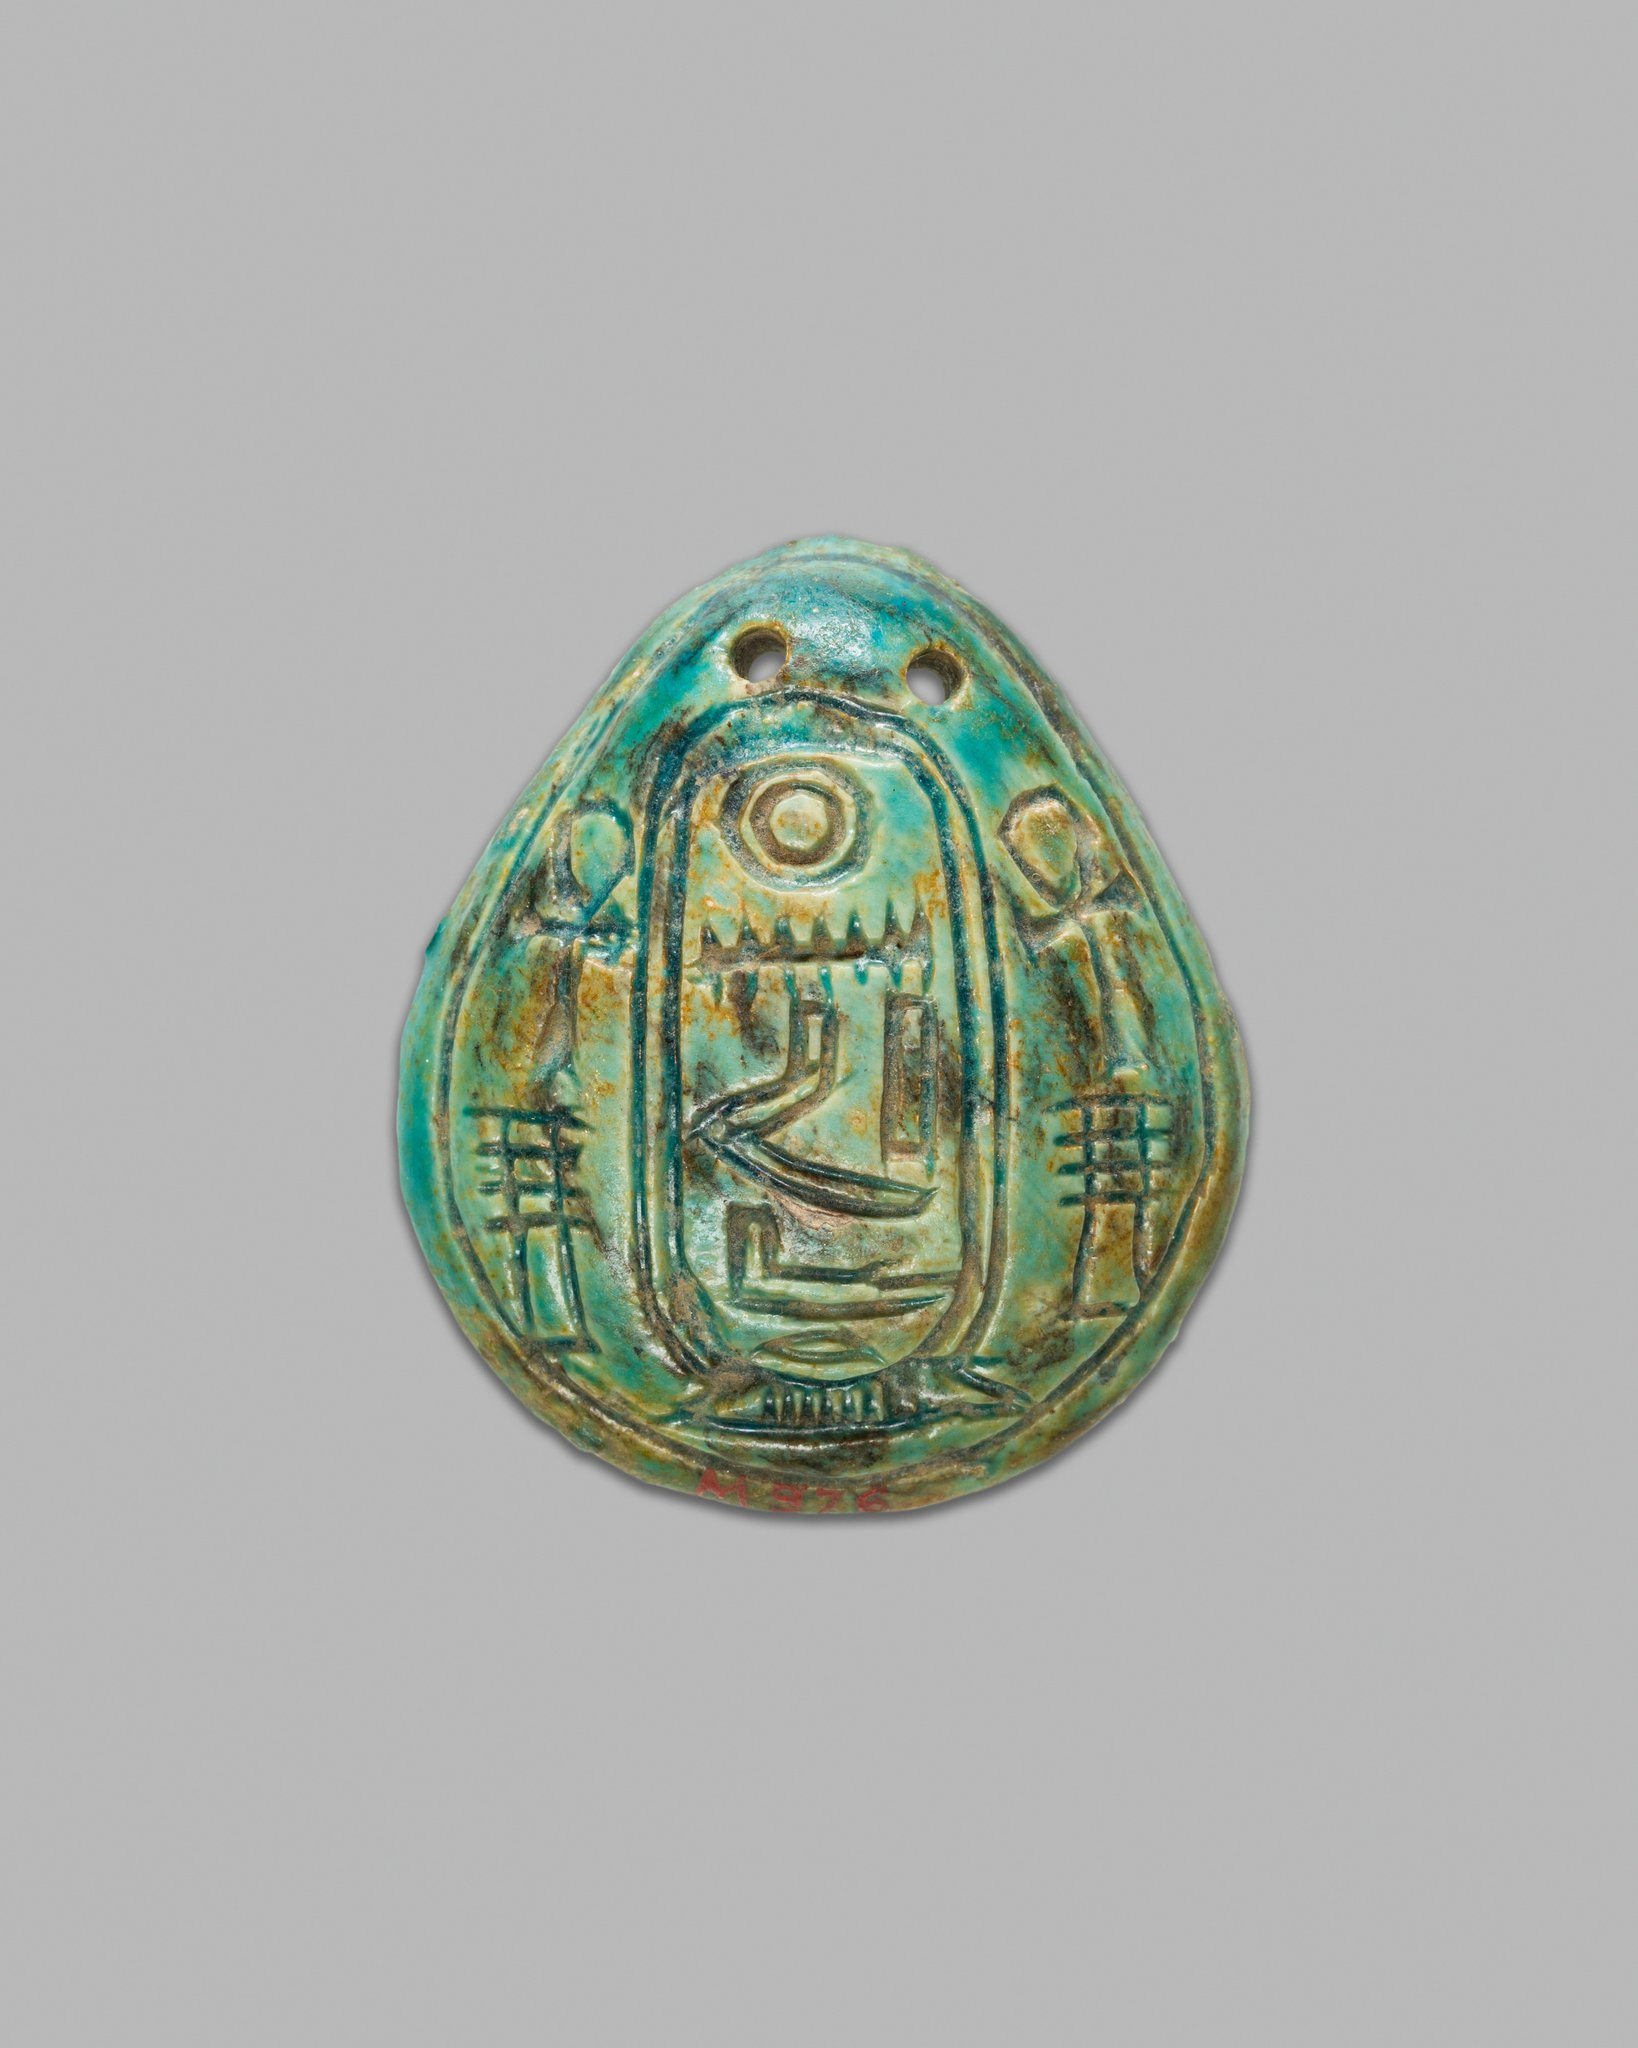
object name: shell amulet inscribed with amenemhat iii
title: Shell amulet inscribed with the name of Amenemhat III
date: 1981-1550 BCE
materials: stone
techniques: glazing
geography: egypt